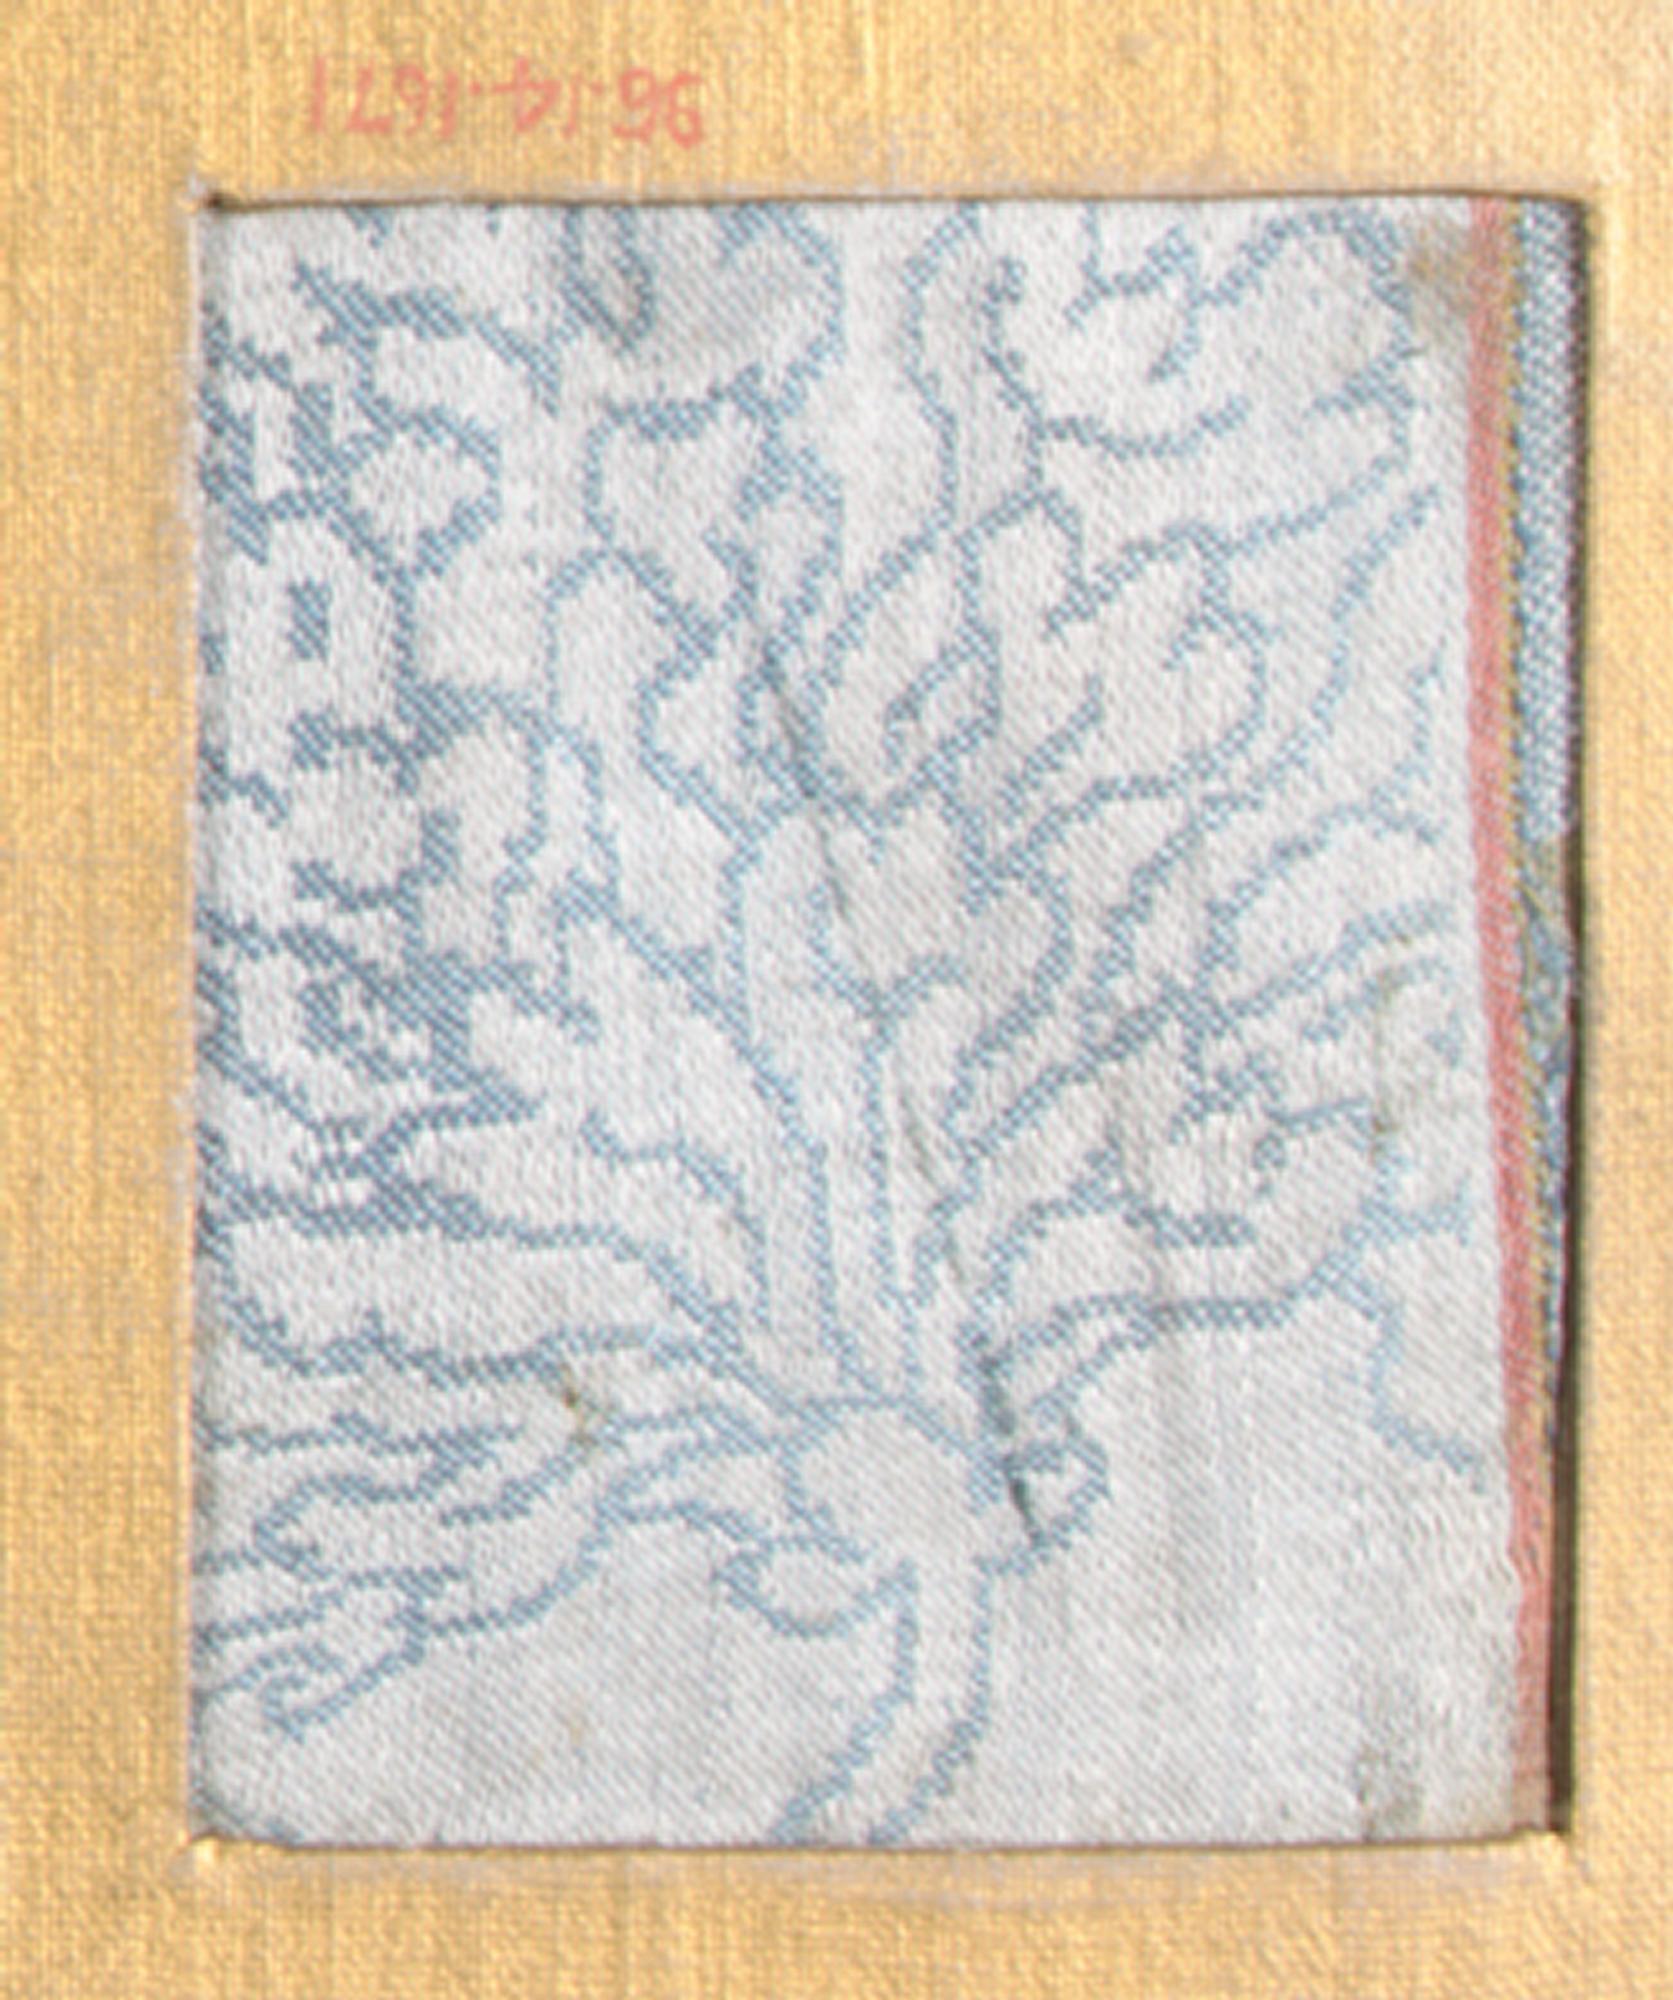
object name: piece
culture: japanese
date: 1701-1900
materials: silk